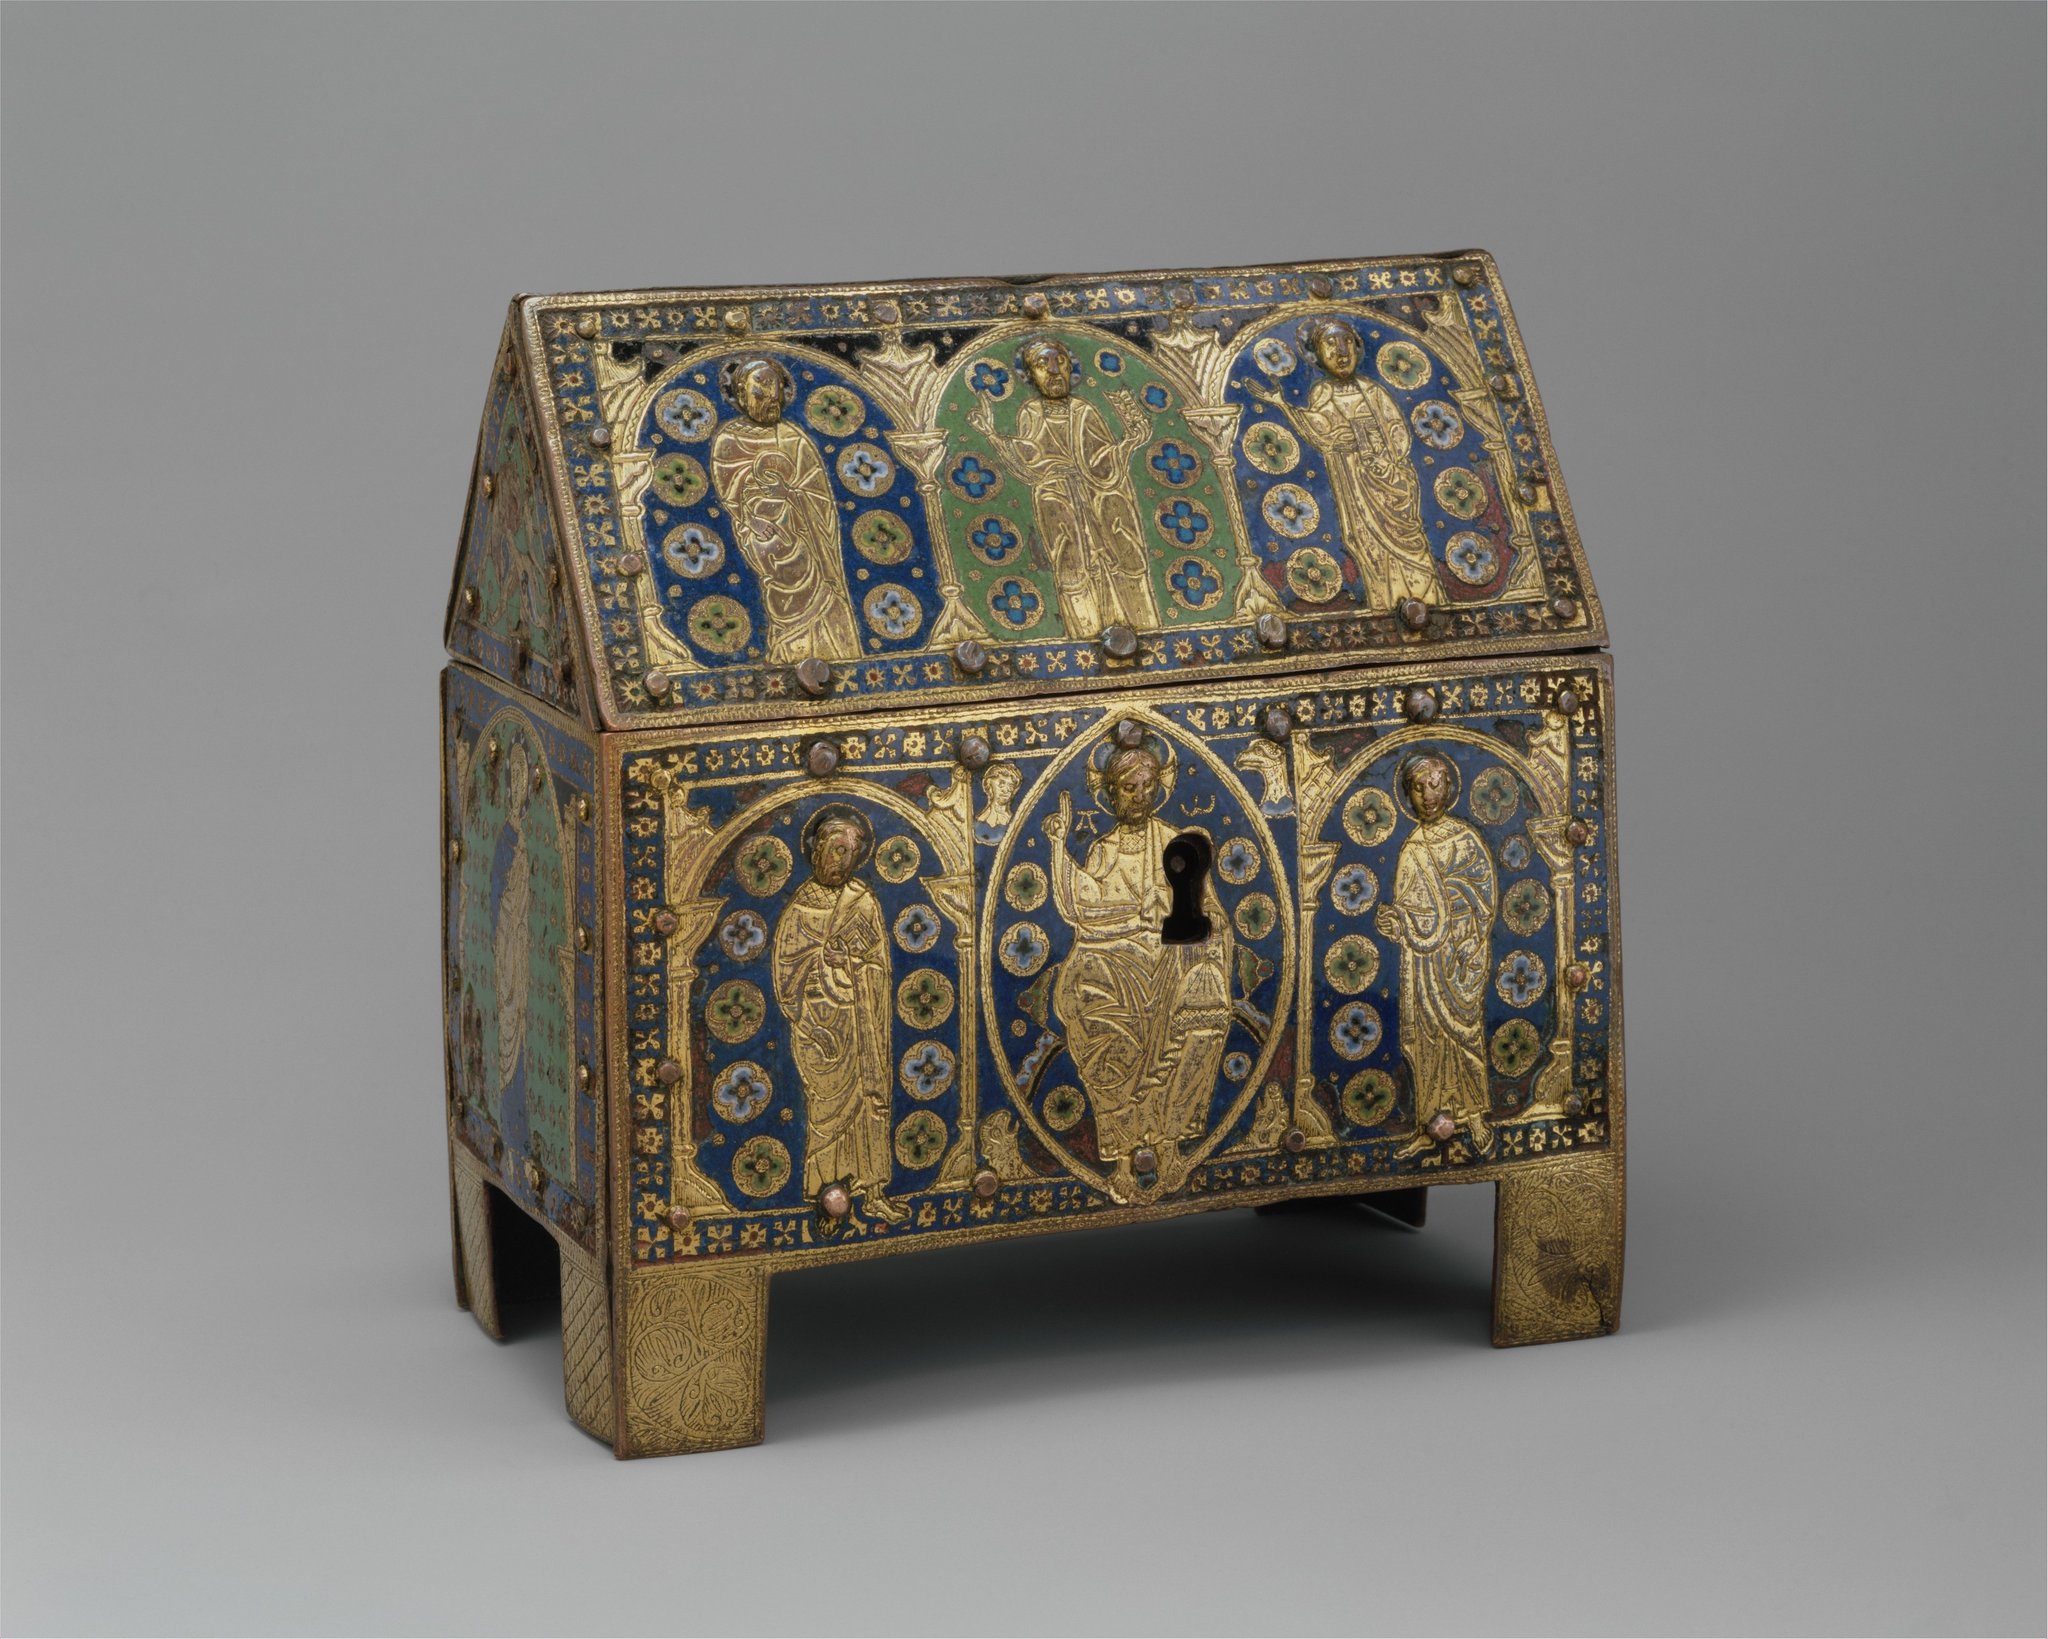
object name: chasse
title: Chasse with Christ in Majesty and Apostles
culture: french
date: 1190-1200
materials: copper, enamel, gilt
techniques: enamel, engraving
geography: france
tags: christ,reliquaries